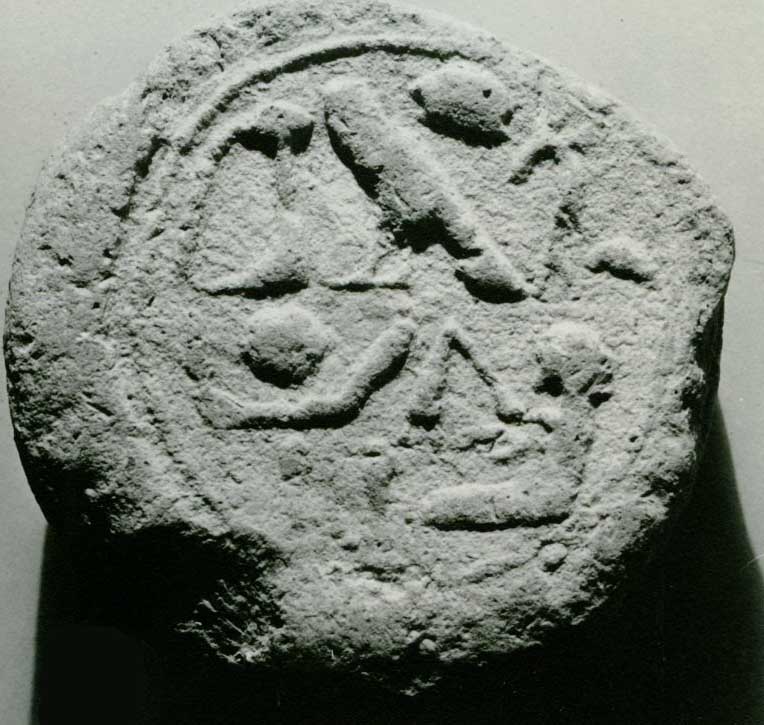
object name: cone, djeserkare, circular impression, khaemwaset, wab priest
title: Funerary Cone of the Wab-Priest Khaemwaset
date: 1550-1295 BCE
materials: pottery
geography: egypt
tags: hieroglyphs